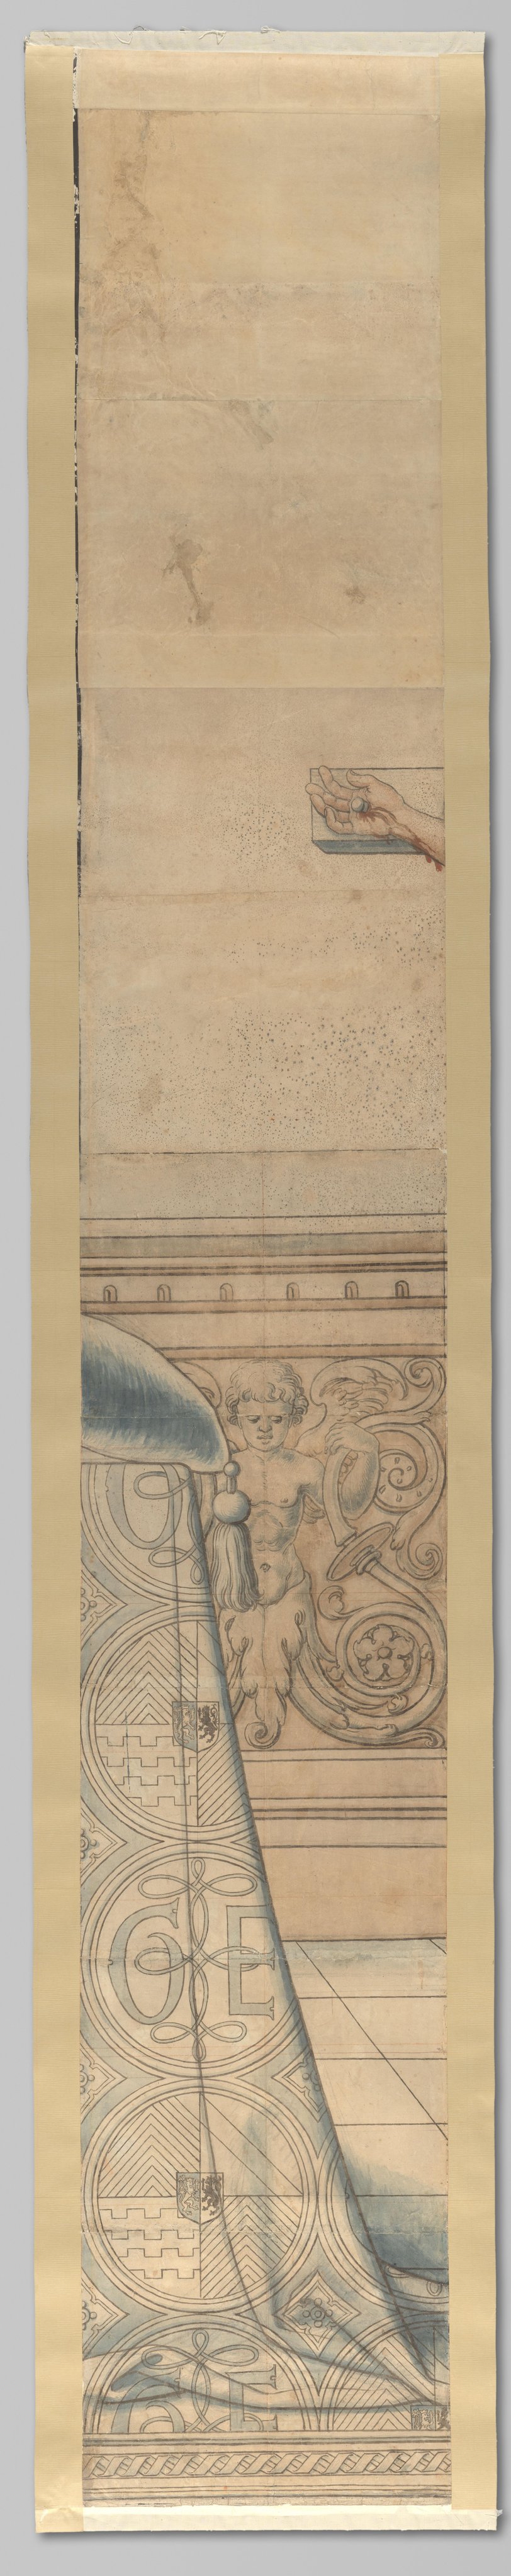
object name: design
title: Fragmenten karton voor het glasraam in de westgevel van Joris van Egmond (Bisschop van Utrecht 1535-1559) voor de Sint Bavo Kerk te Haarlem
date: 1541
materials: chalk, charcoal, paper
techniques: brush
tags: clergyman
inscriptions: date